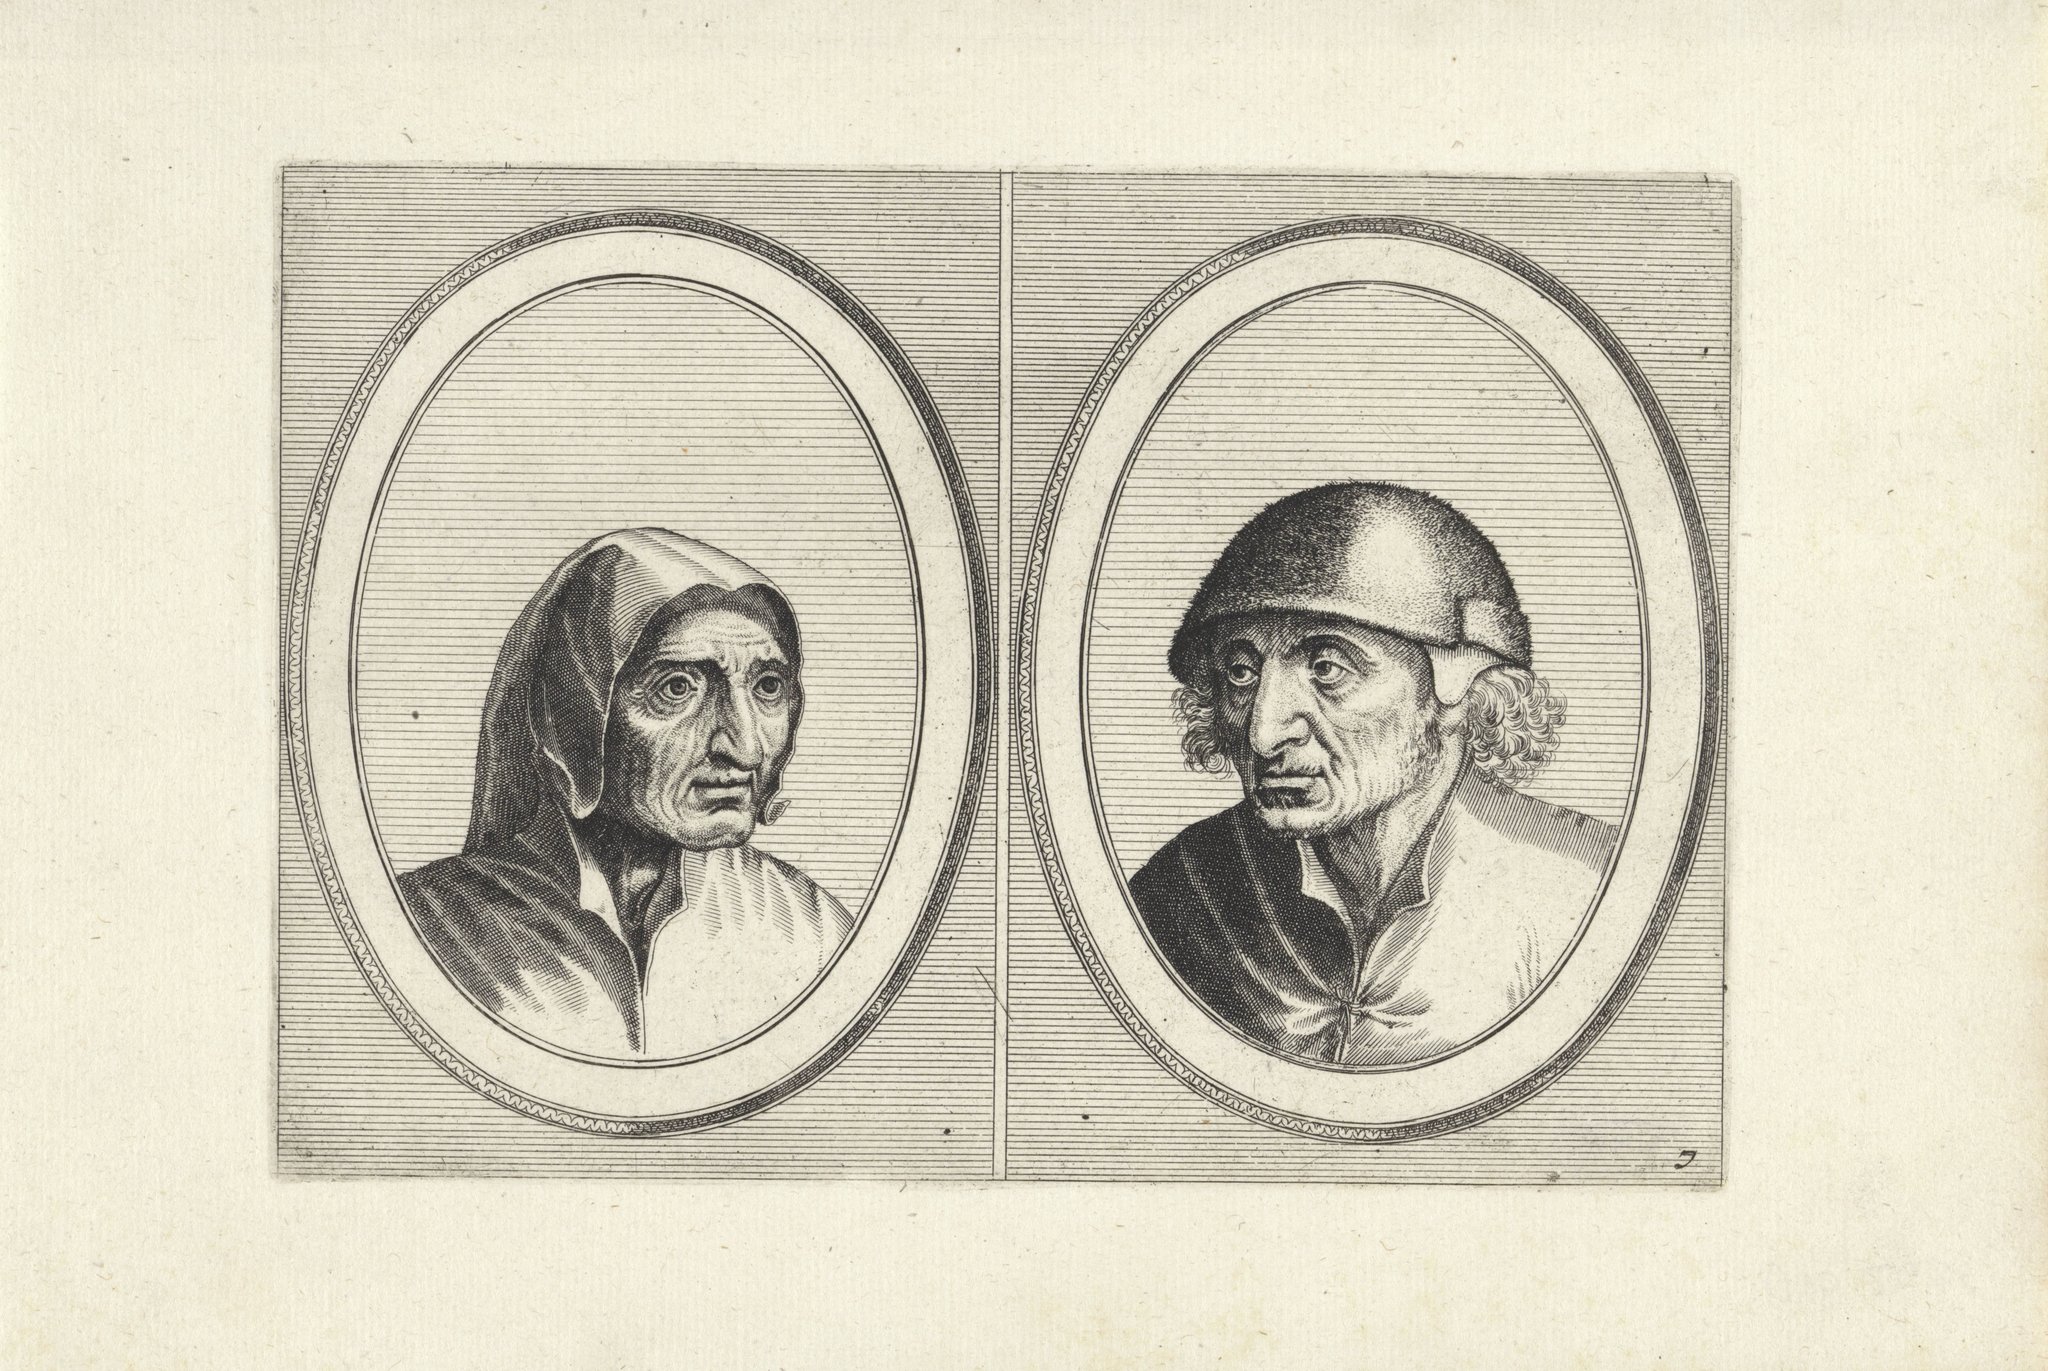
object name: print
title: Rijckje Schimmel-penninghs en Lubbert Leever-worst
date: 1612-1652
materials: paper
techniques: engraving, etching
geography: amsterdam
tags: head-gear, farmers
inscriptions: collector's mark: Lugt 2228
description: Prent uit een serie van 36 prenten met koppen van boeren en boerinnen.